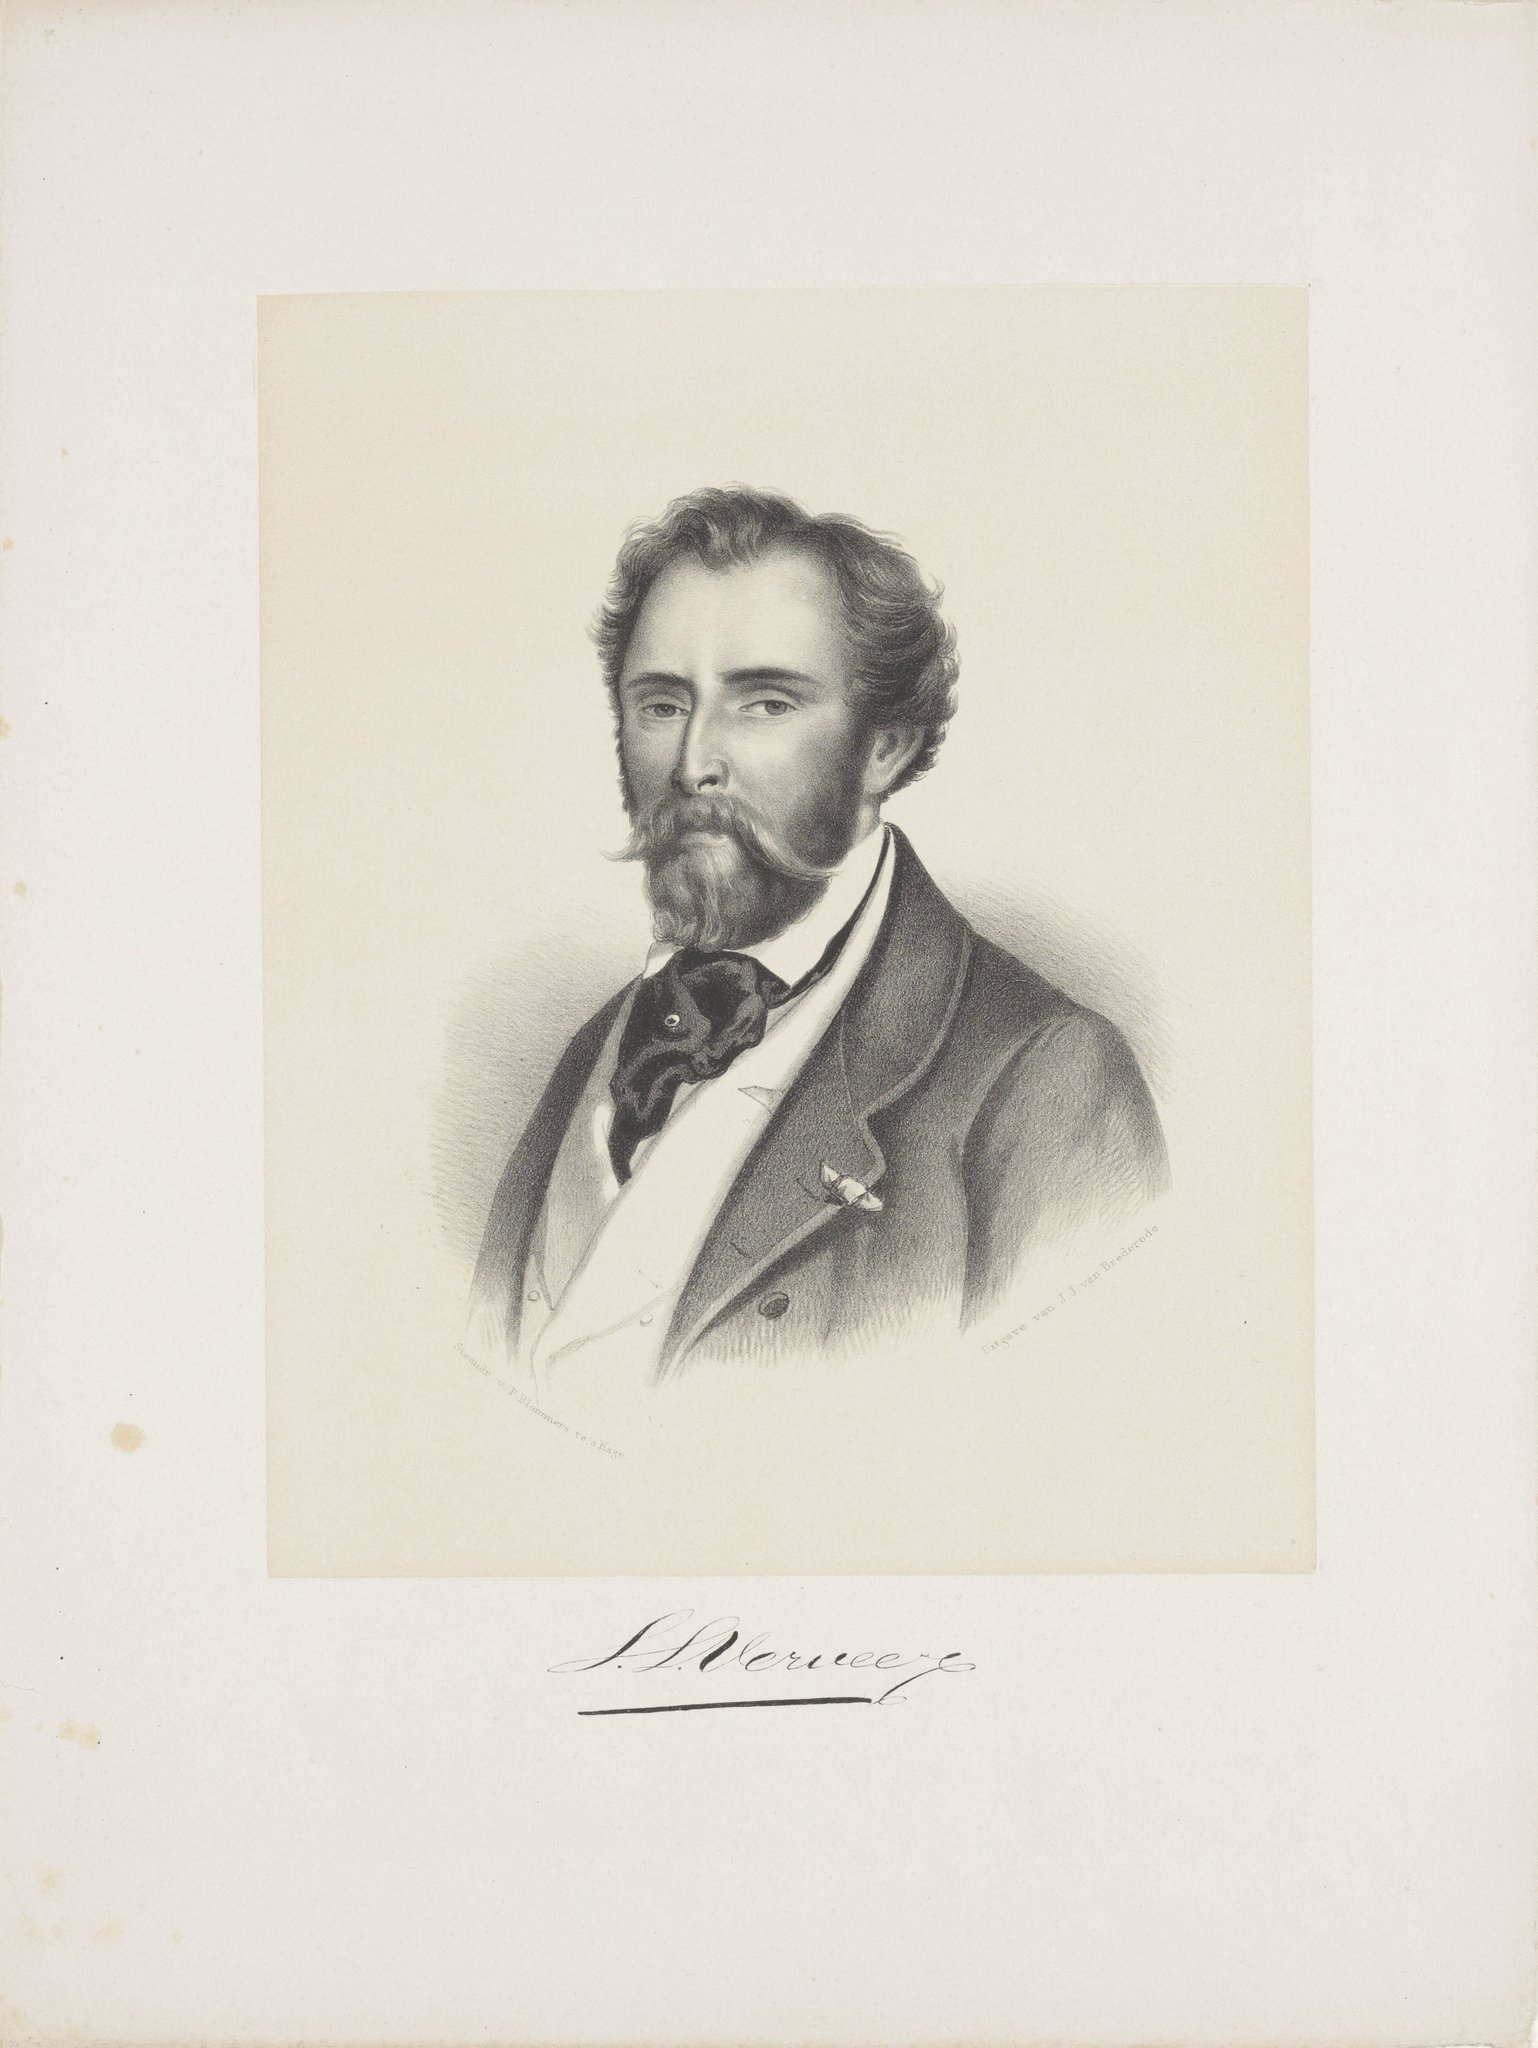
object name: print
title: Portret van Samuel Leonardus Verveer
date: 1847-1887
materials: paper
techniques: tone lithography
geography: the hague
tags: the hague, salomon leonardus verveer, knighthood order, historical persons (+ (full) bust portrait)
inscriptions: collector's mark: Lugt 2228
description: Borststuk naar links. De geportretteerde draagt een cravate met een speld. Op de revers van zijn jas draagt hij een lintje. Onder het portret zijn signatuur.